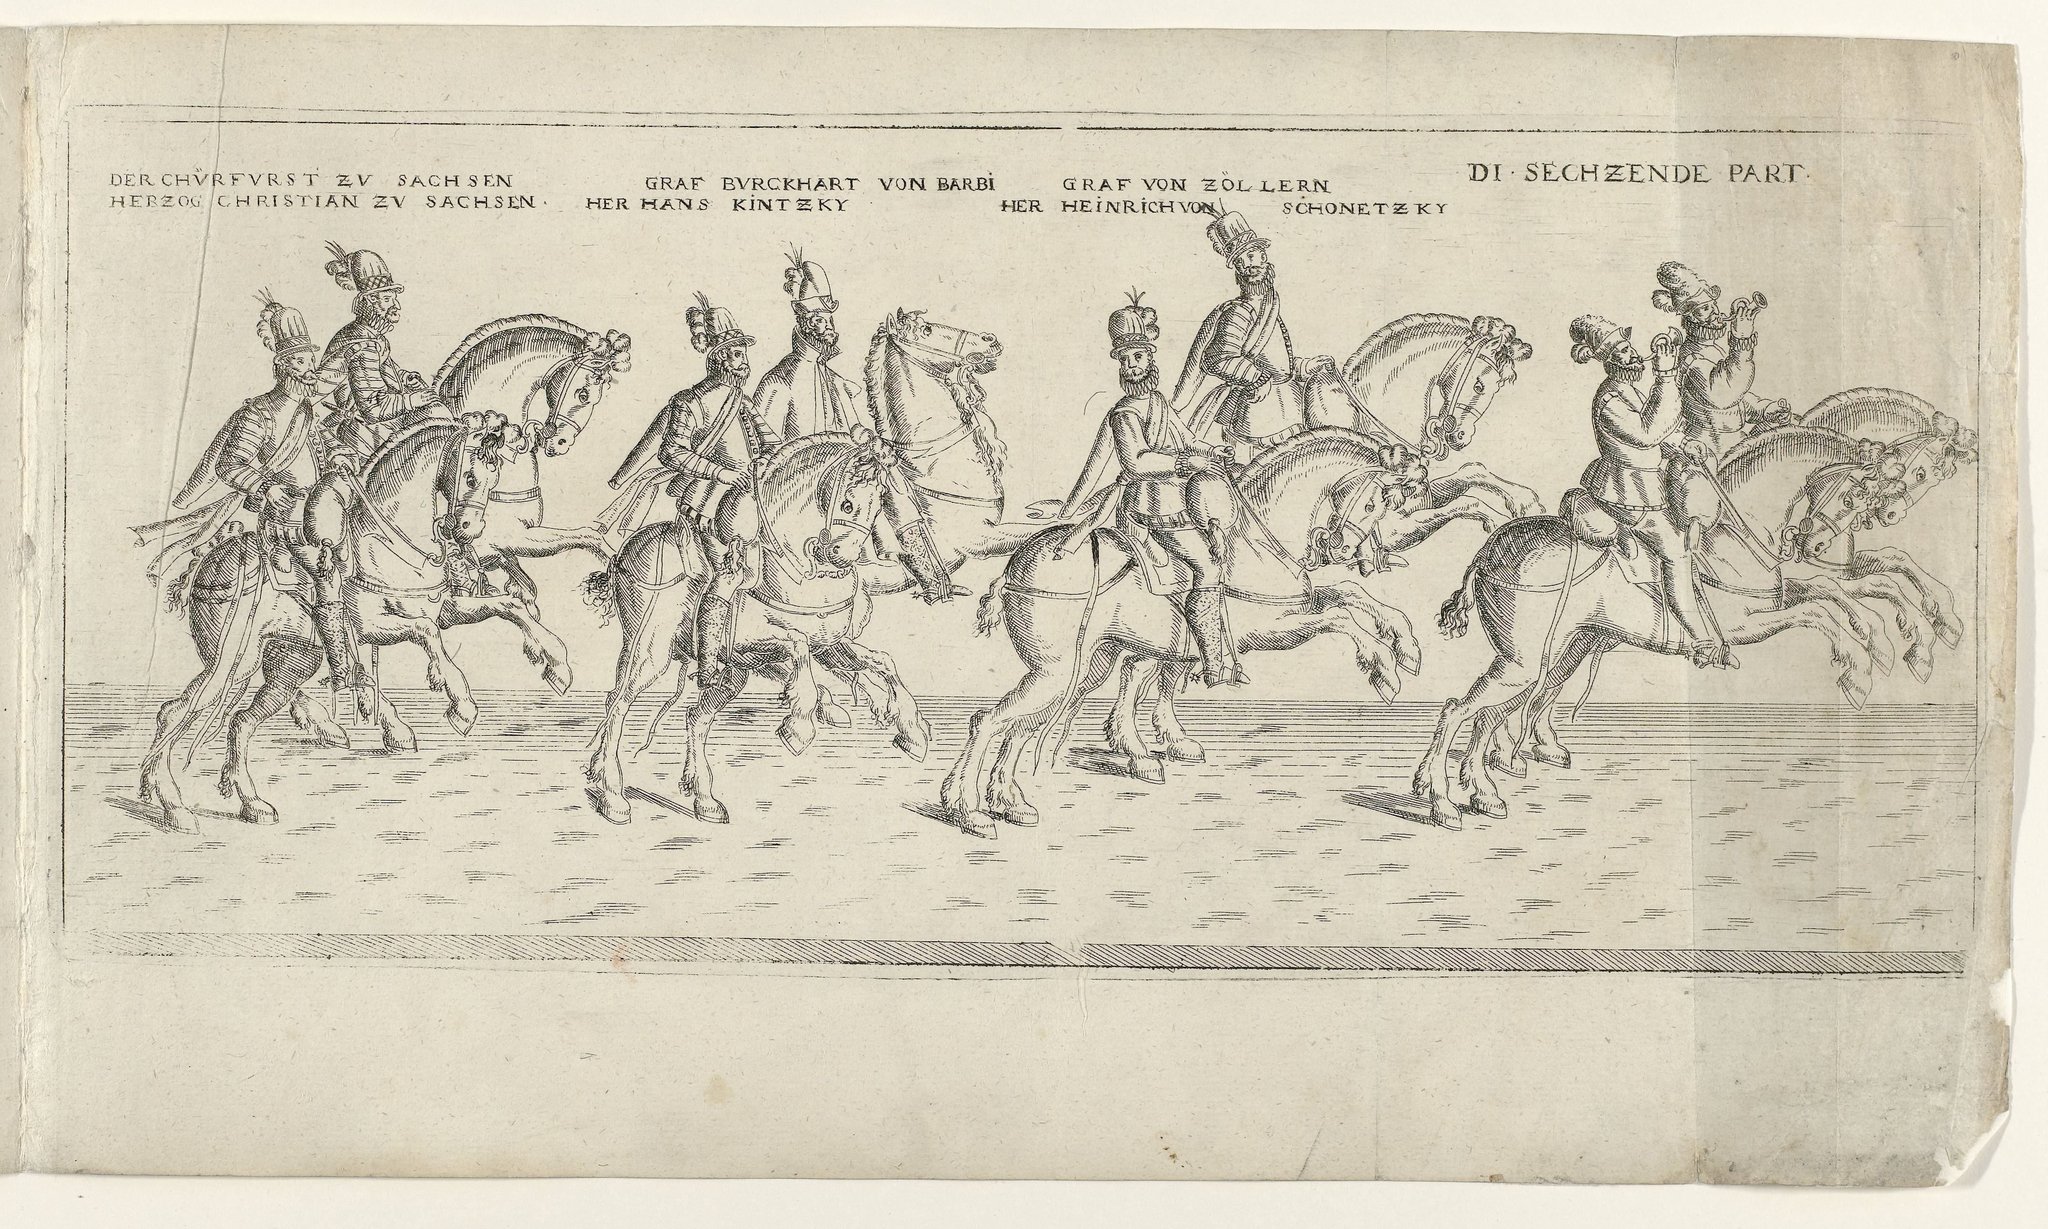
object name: print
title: Stoet met edelen Churfurst zu Sachsen, Herzog Christian zu Sachsen, Graf Burckhart von Barbi, Her Hans Kintzky, Graf von Zöllern en Her Heinrich von Schonetzky met hoornblazers te paard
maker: Anonymous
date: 1553-1586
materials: paper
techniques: etching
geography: germany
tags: riding a horse, ass, or mule; rider, horseman, dress-up party, rejoicing on special occasions (+ parade, pageant, cavalcade ~ festive activities)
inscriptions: collector's mark: Lugt 2760, collector's mark: Lugt 2228